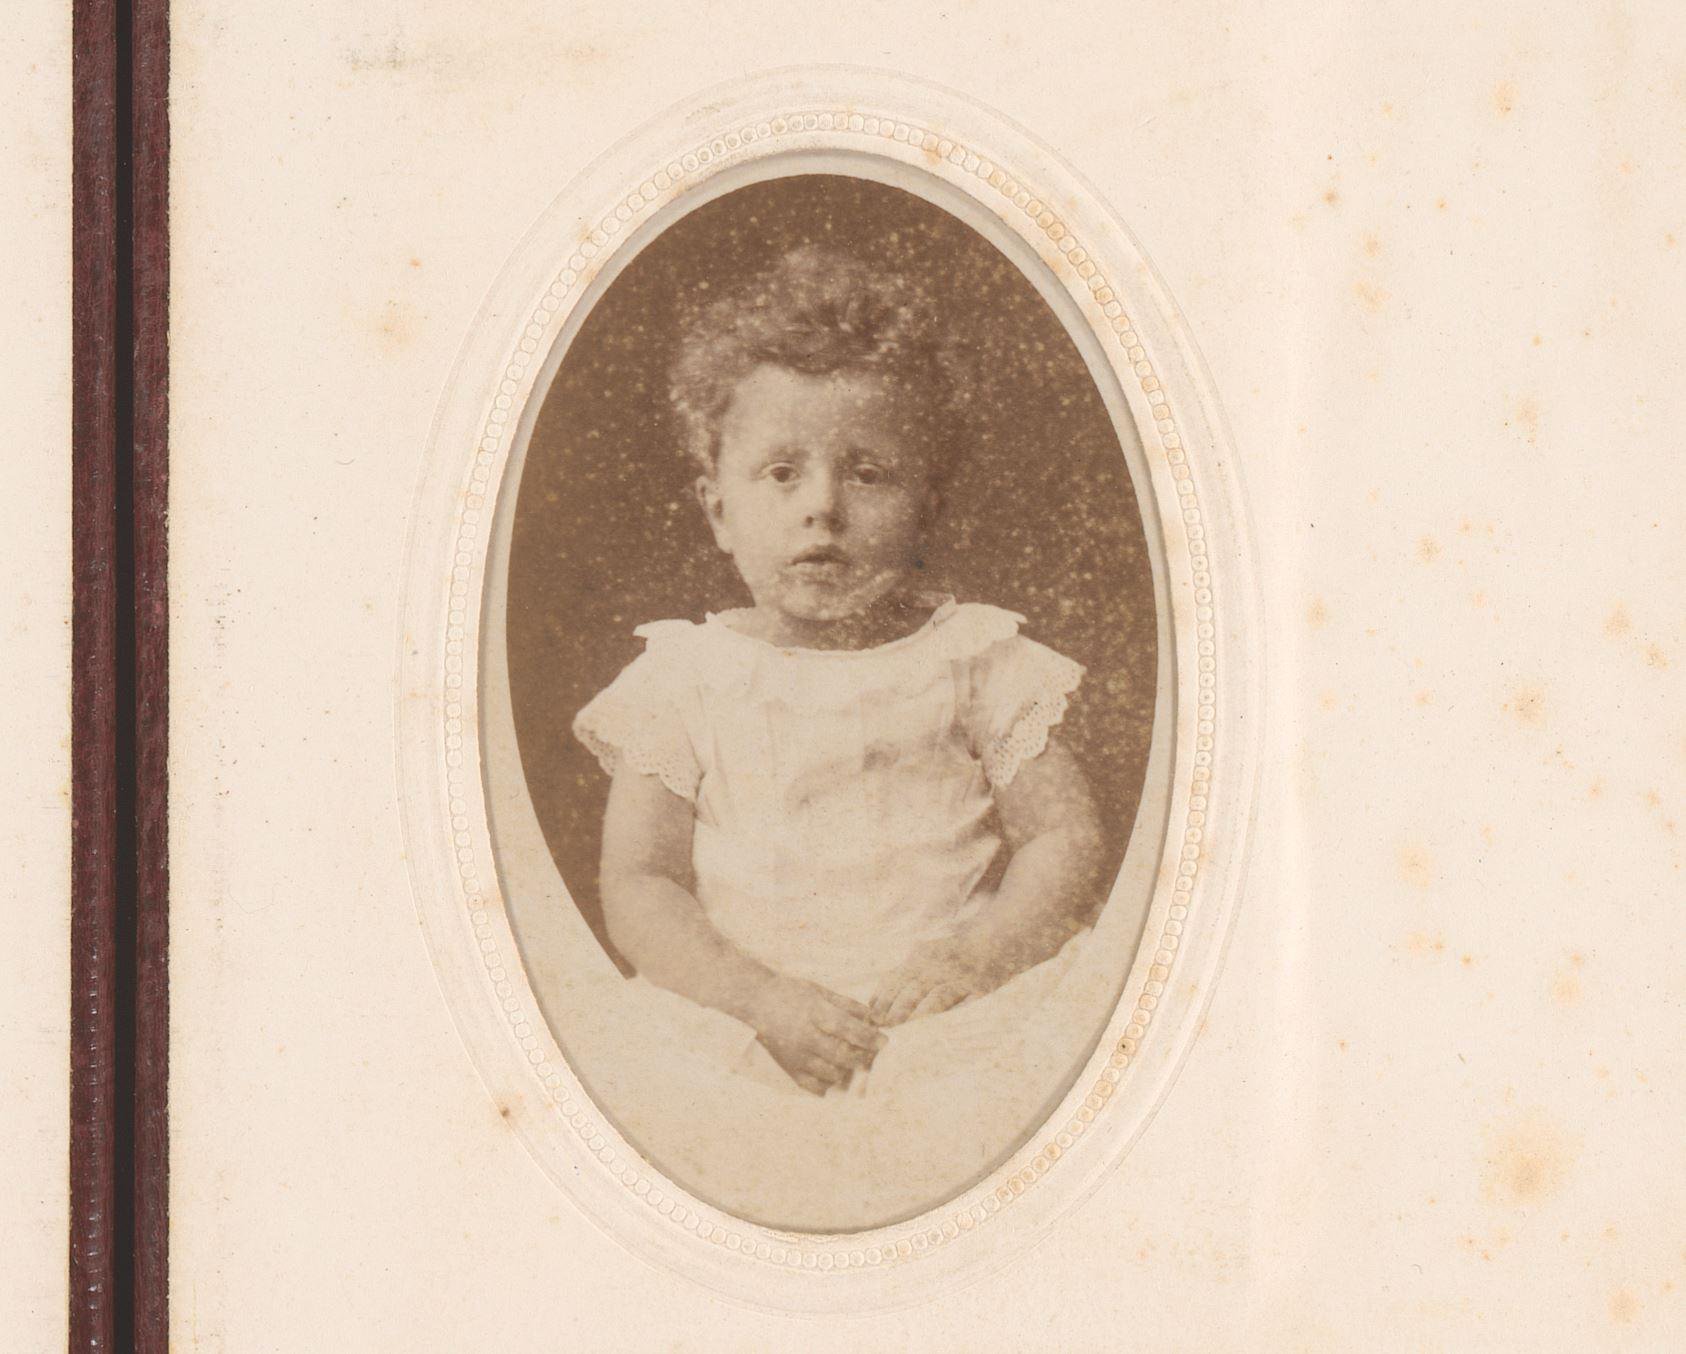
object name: photograph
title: Portret van een kind in witte jurk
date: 1877-1884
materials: cardboard, photographic support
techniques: albumen print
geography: amsterdam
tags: historical persons, tot, toddler ~ the ages of man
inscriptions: inscription: ‘American/ photography/ Hisgen Bros./ 128, P.C. HOOFTSTRAAT/ Amsterdam’